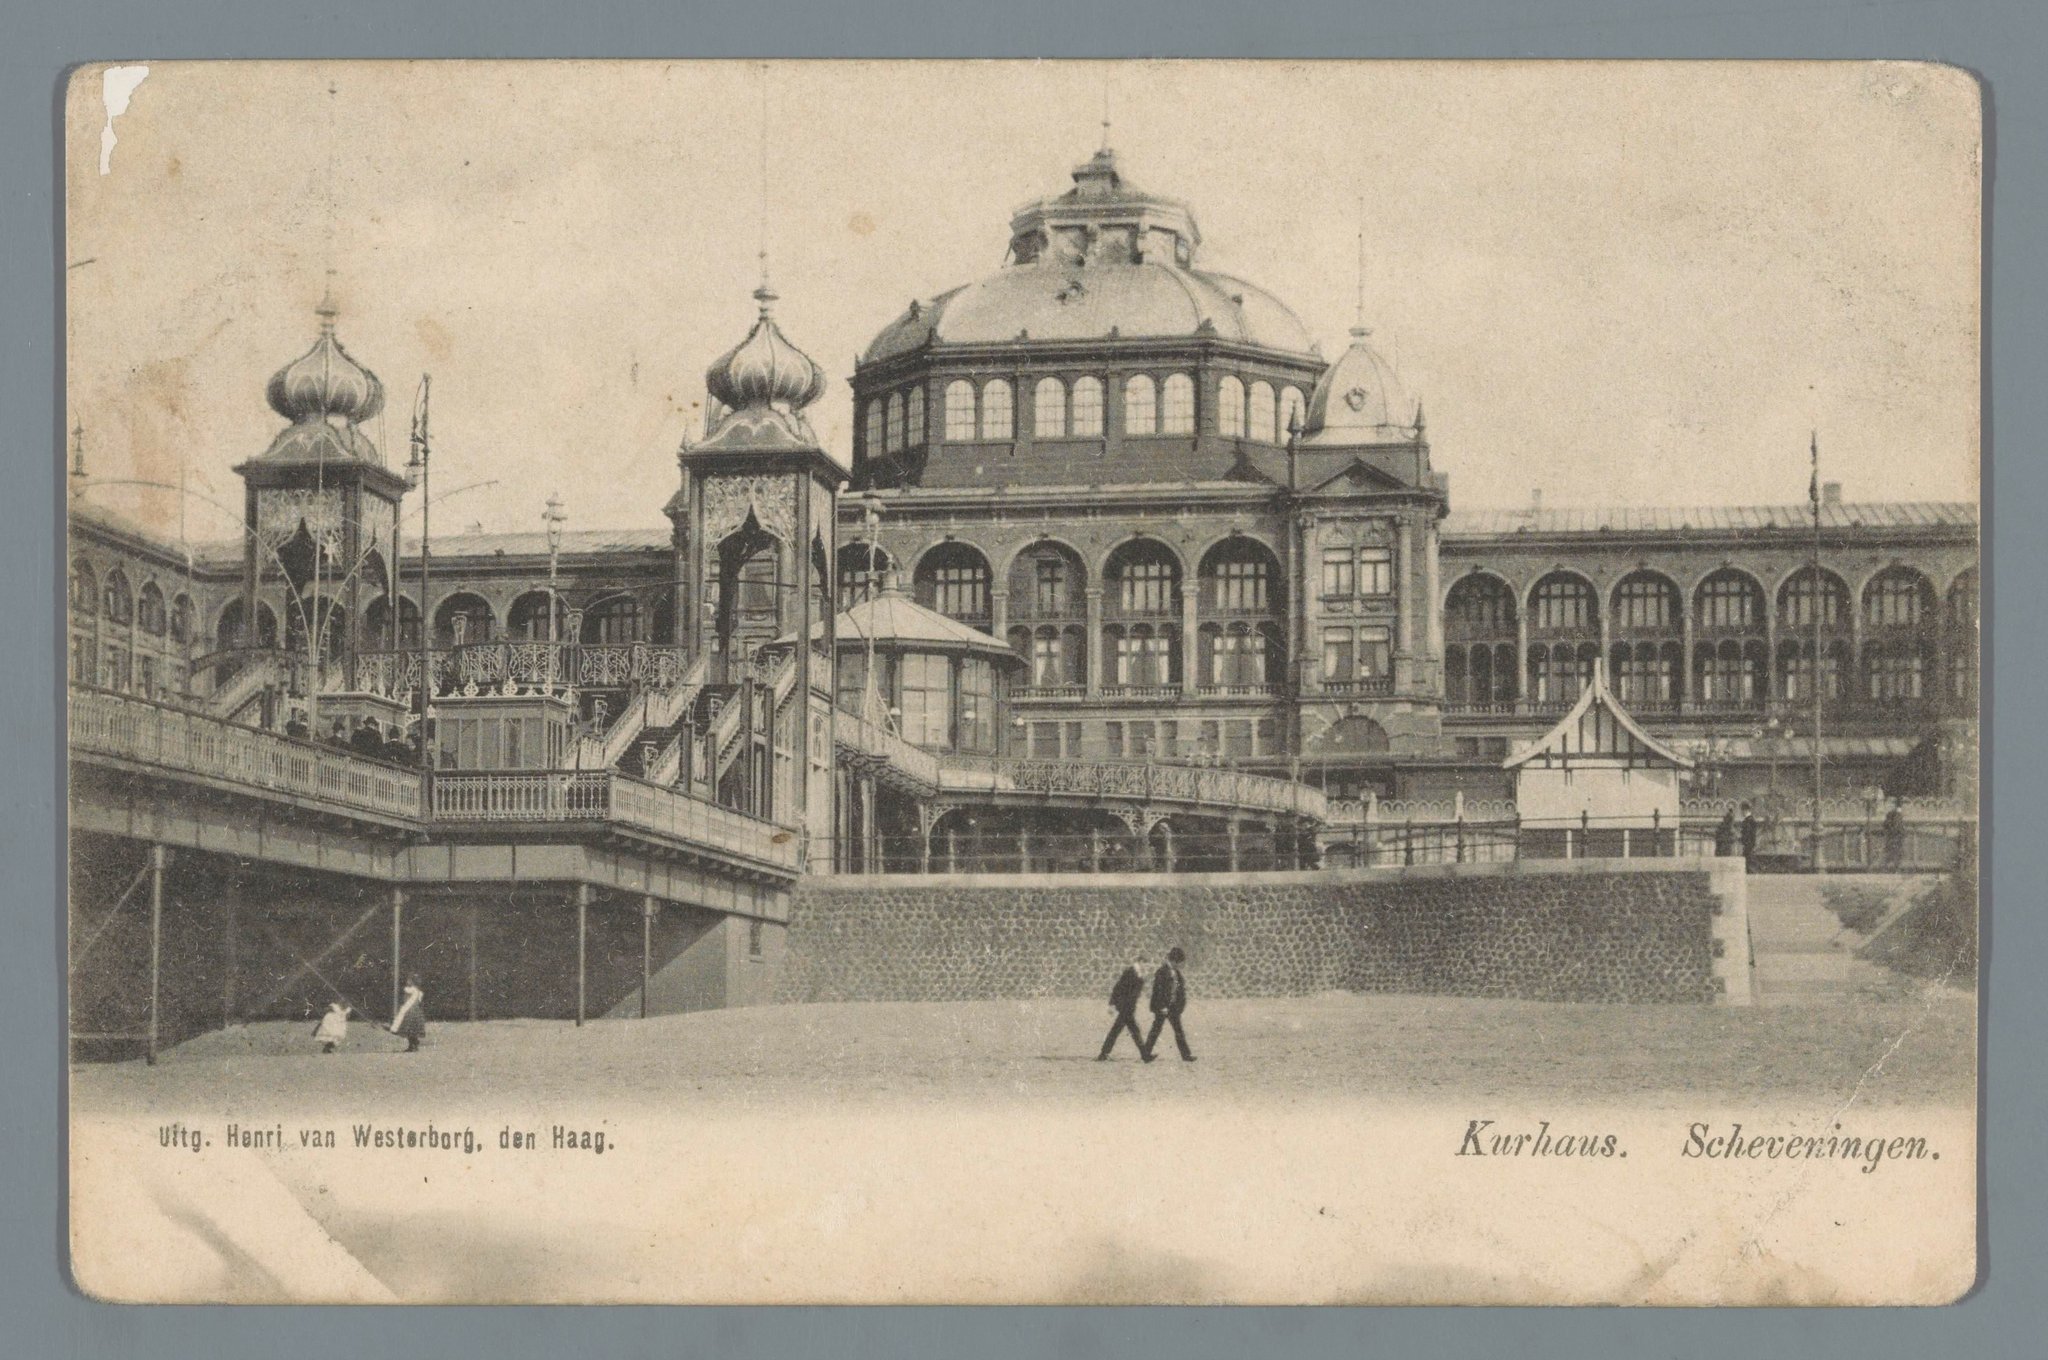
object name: photograph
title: Kurhaus. Scheveningen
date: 1890-1920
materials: cardboard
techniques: photograph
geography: scheveningen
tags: hotel, hostelry, inn